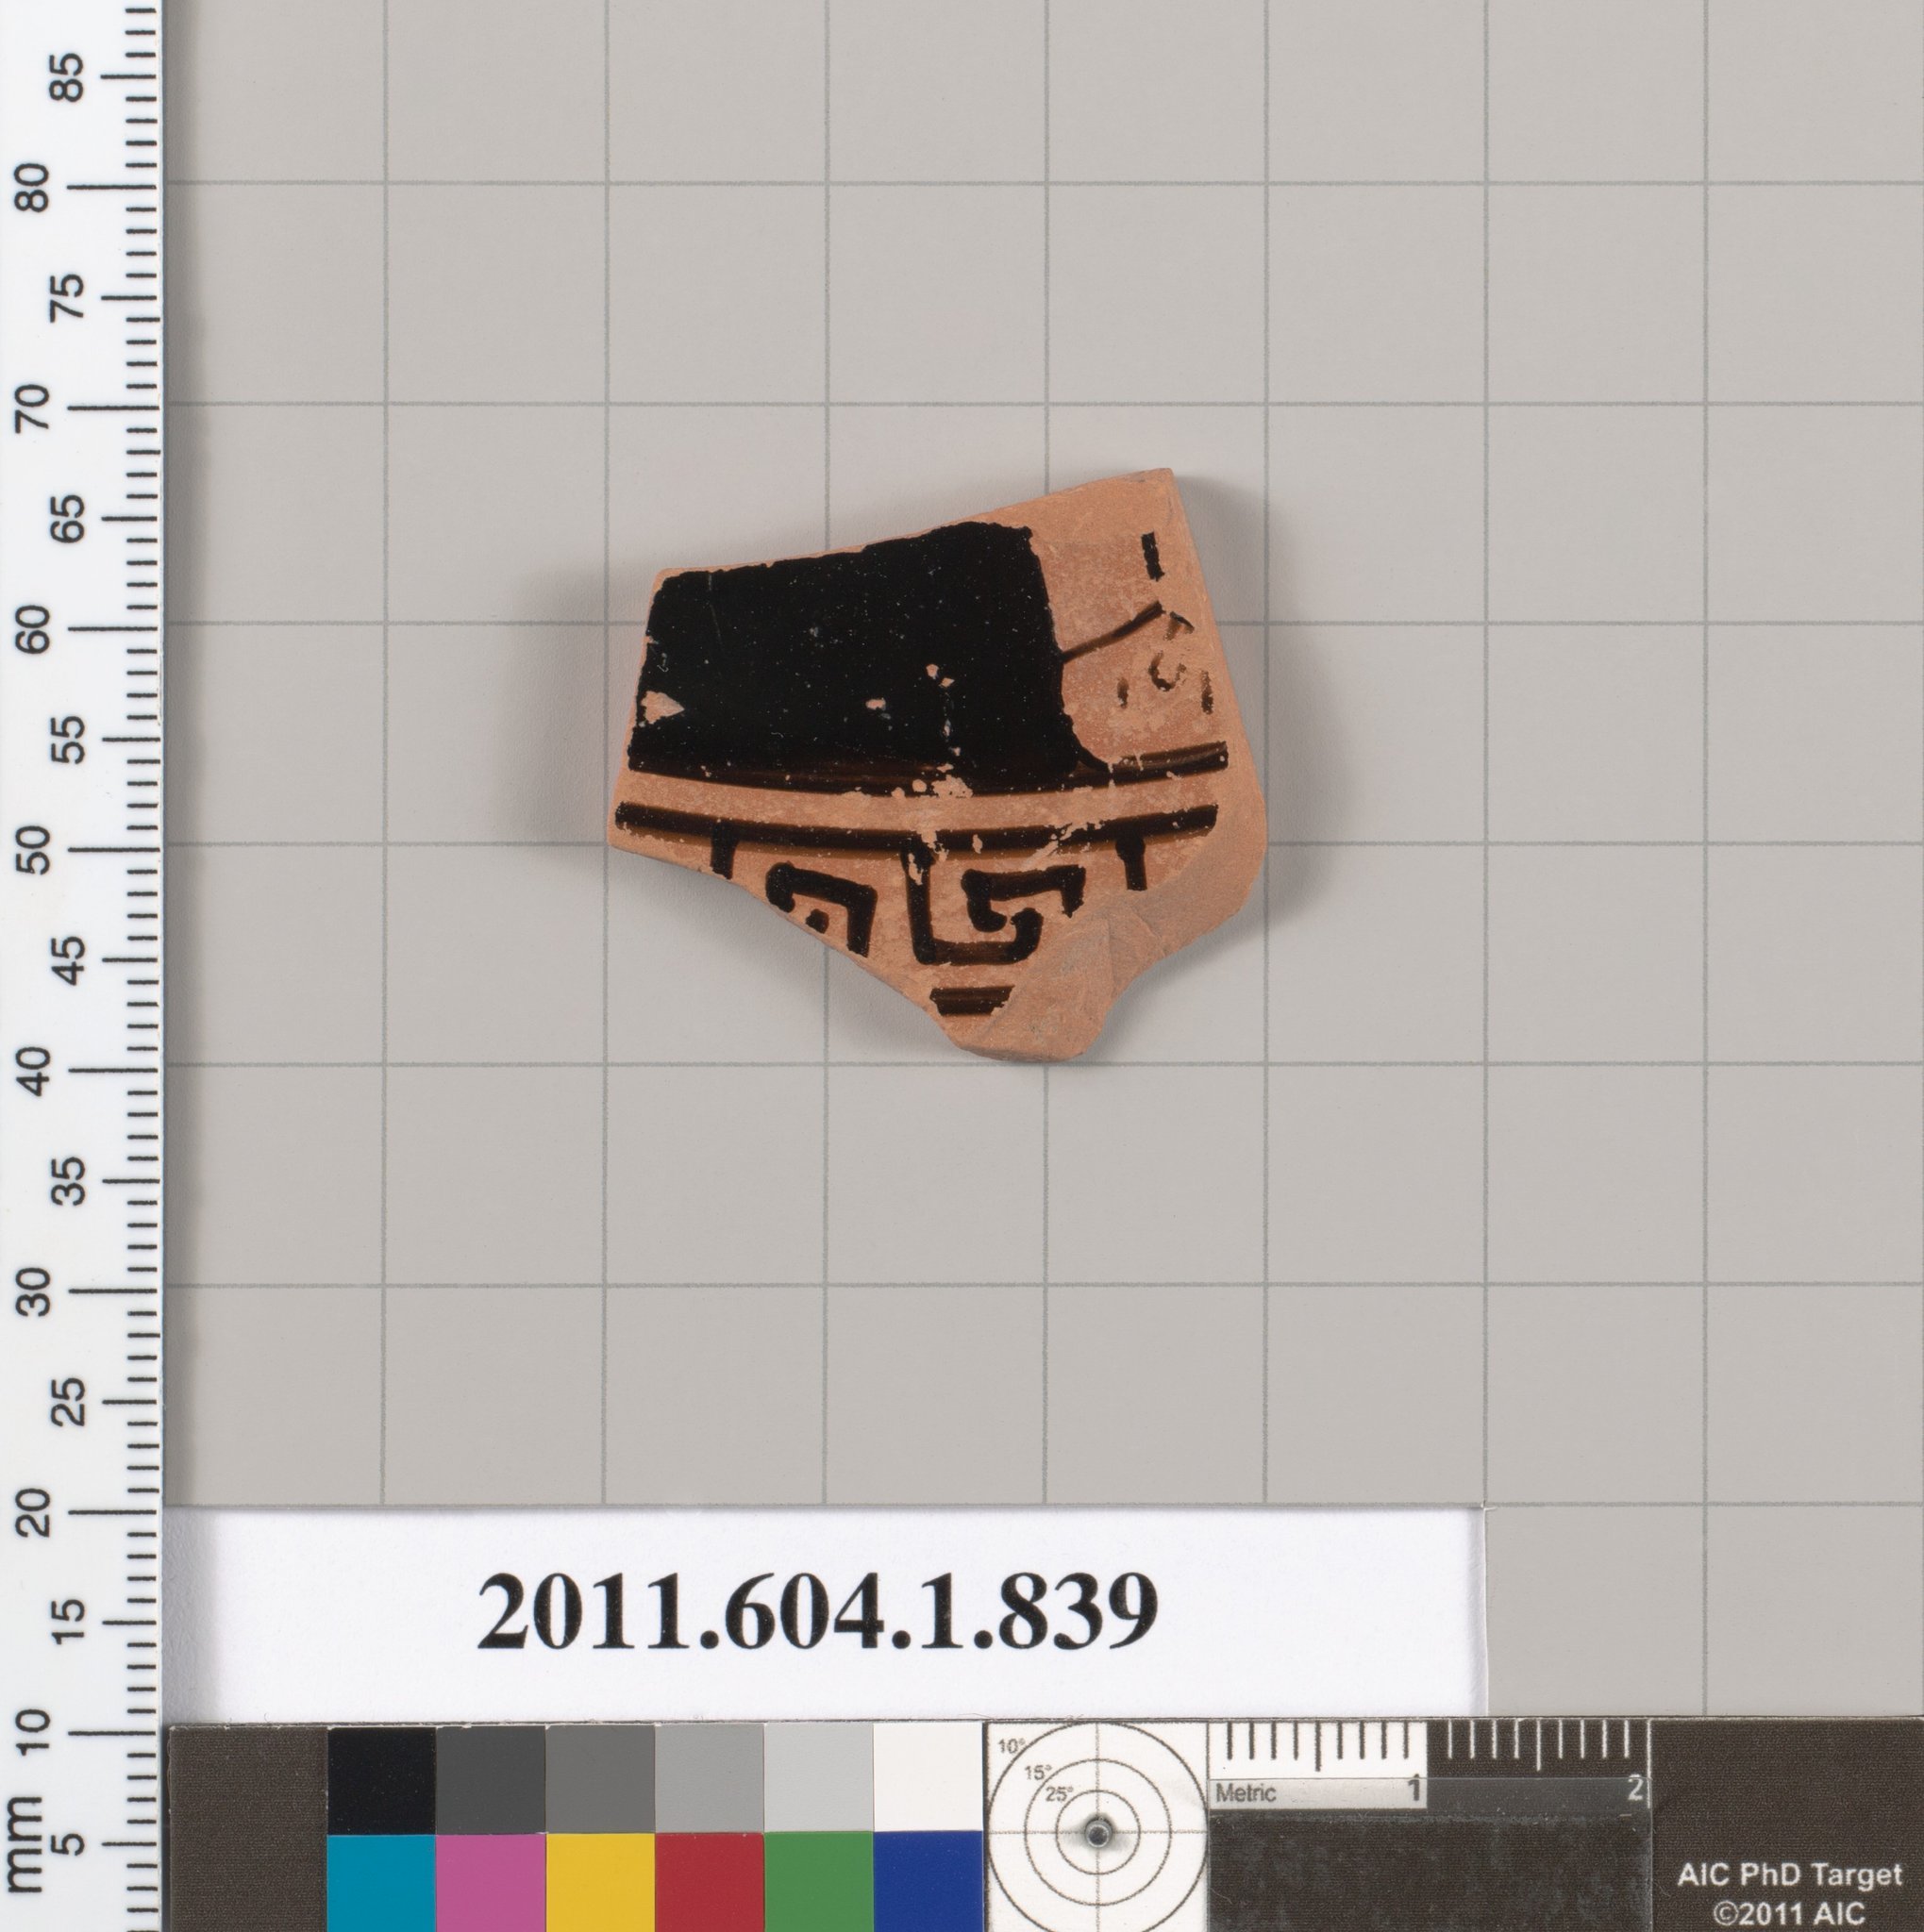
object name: kylix fragment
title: Terracotta fragment of a kylix (drinking cup)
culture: greek, attic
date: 475-451 BCE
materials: terracotta